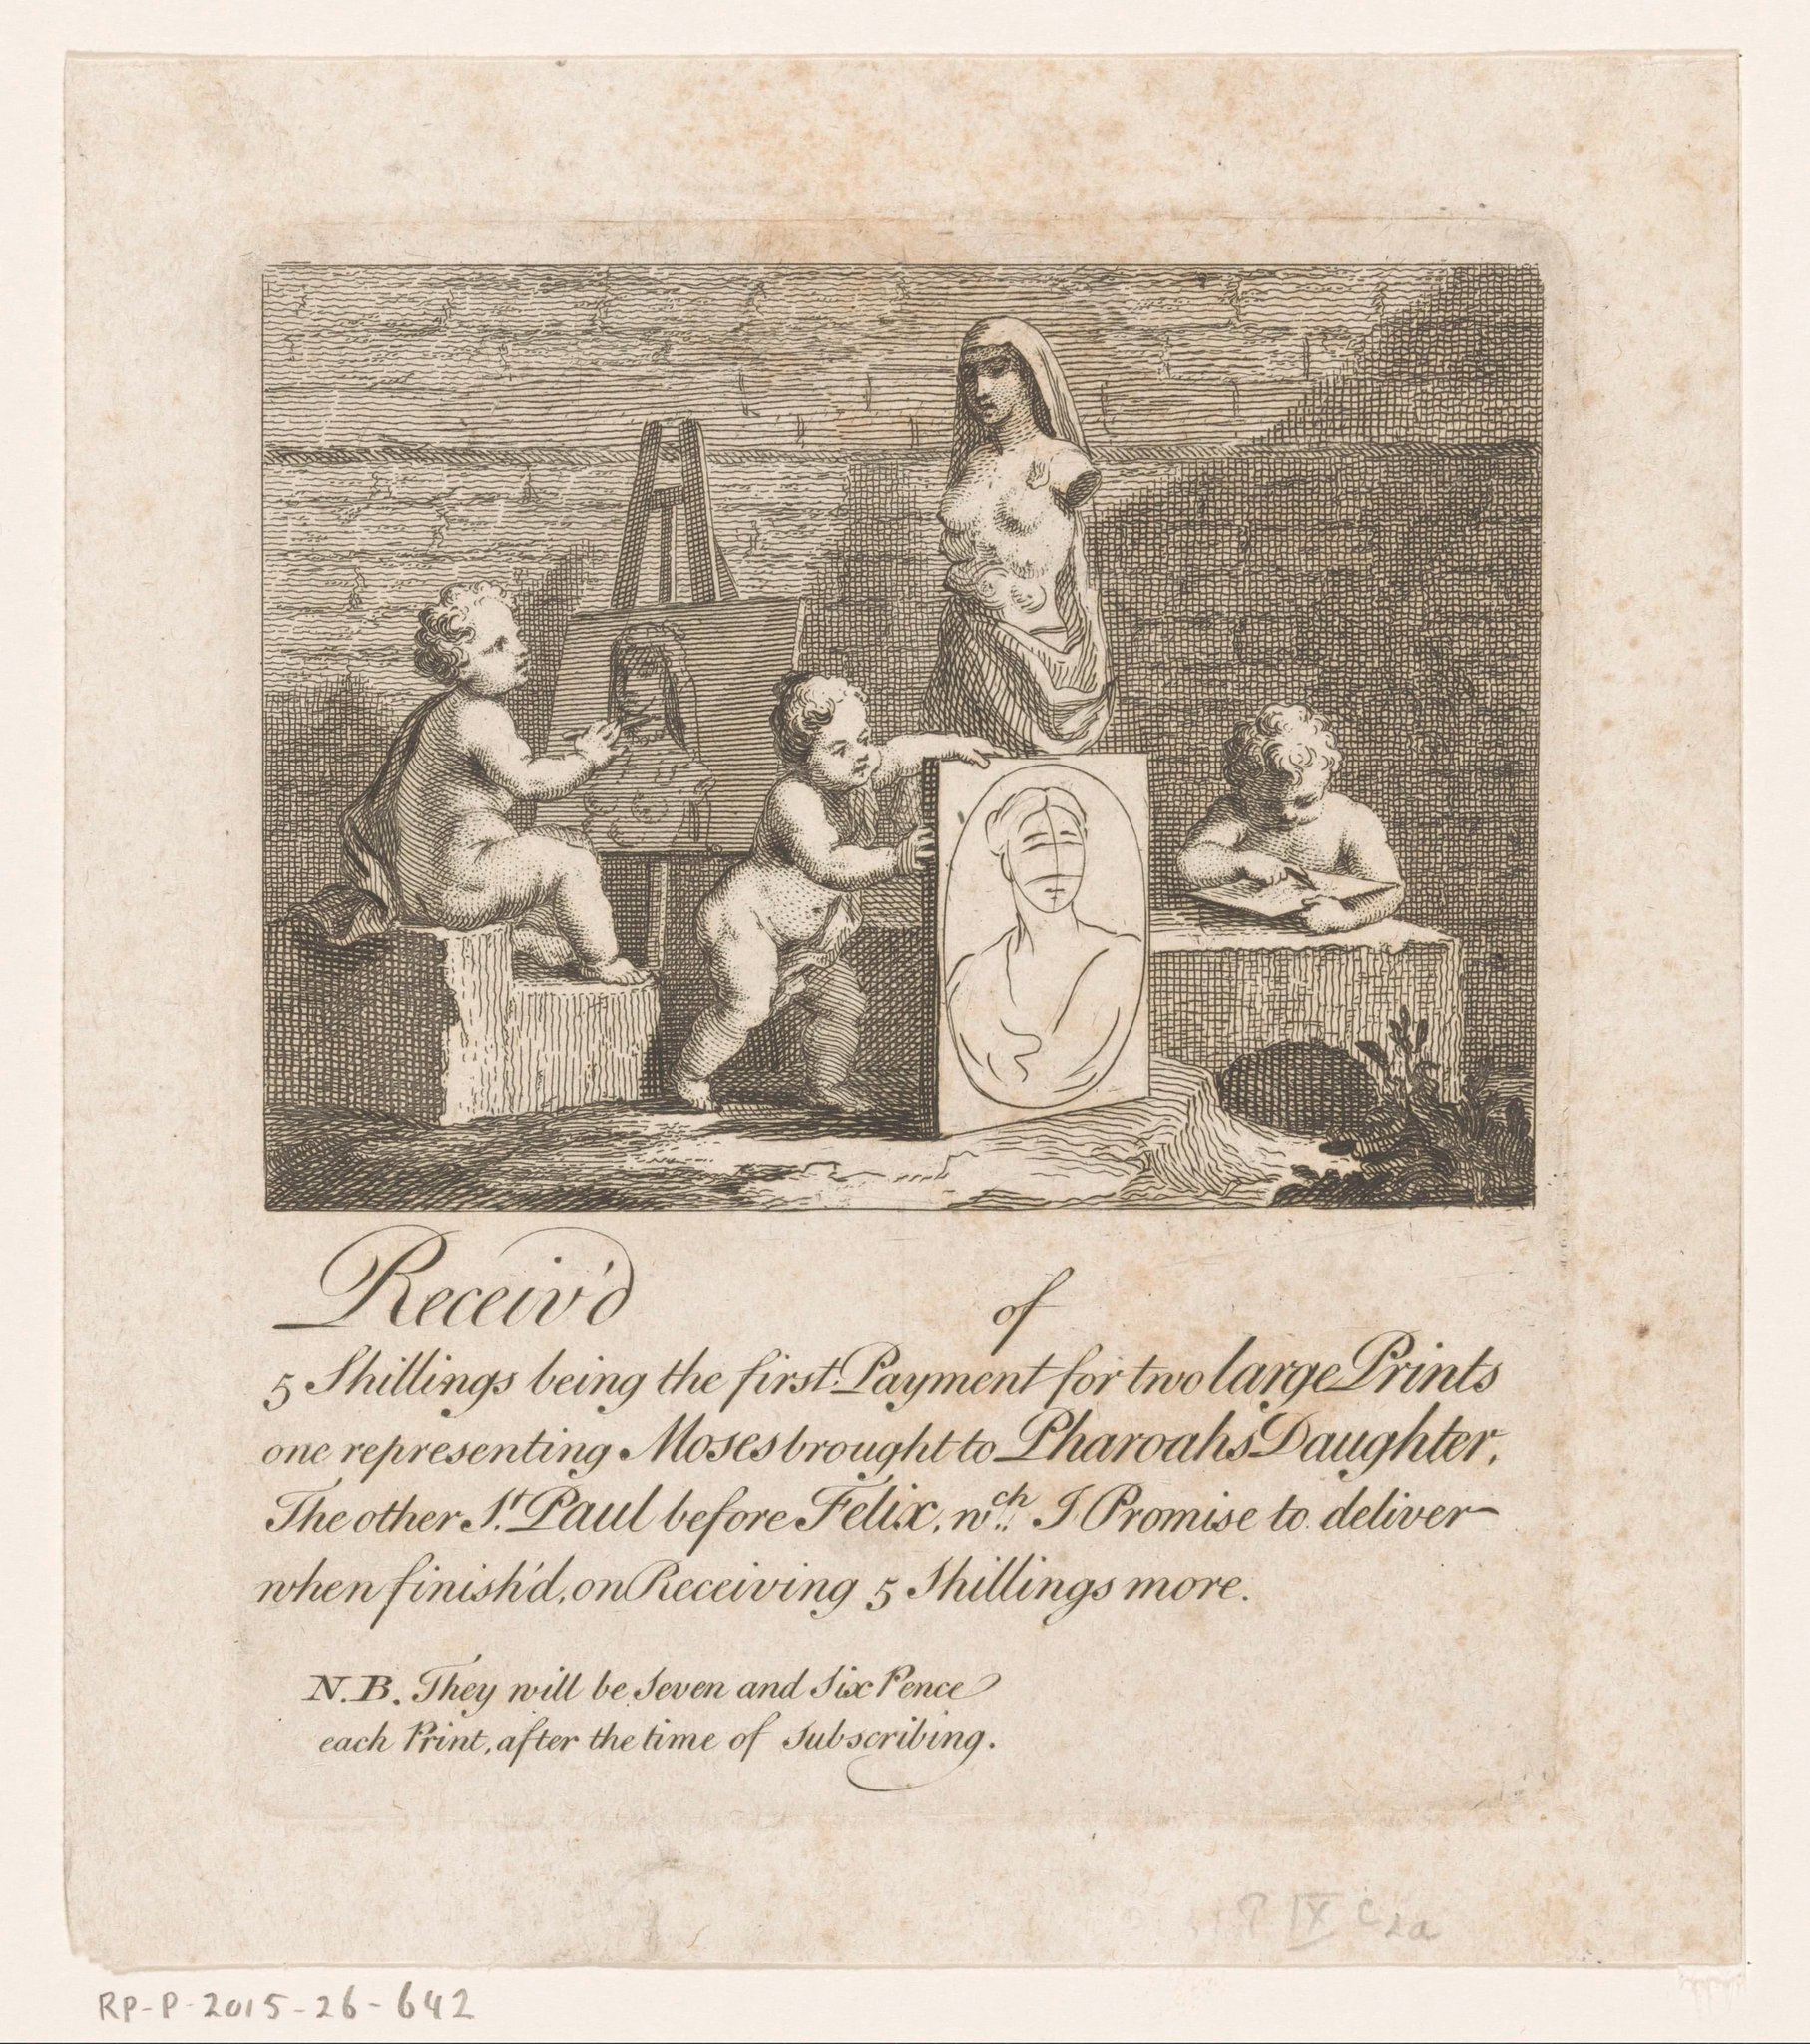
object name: ontvangstbewijs, kwitantie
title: Drie putti en een beeld van Natura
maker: william hogarth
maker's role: draughtsman, painter, print maker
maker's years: 1697-1764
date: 1731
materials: paper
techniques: engraving, etching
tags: 'natura' (allegorical figure or scene; or as diana of ephesus, with many breasts); 'natura' (ripa), engraver, etcher, painting (including book-illumination, miniature-painting), cupids: 'amores', 'amoretti', 'putti'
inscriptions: collector's mark: Lugt 4779, collector's mark: Lugt 2228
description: Kwitantie voor de betaling van 5 shilling voor twee prenten met als voorstellingen: Moses voor de dochter van de Farao en Paulus voor Felix. Waarschijnlijk gaat het om twee prenten gegraveerd door Luke Sullivan naar ontwerp van William Hogarth. De kwitantie werd eerder gebruikt voor andere prenten, als eerste voor A Harlots Progress in 1731.